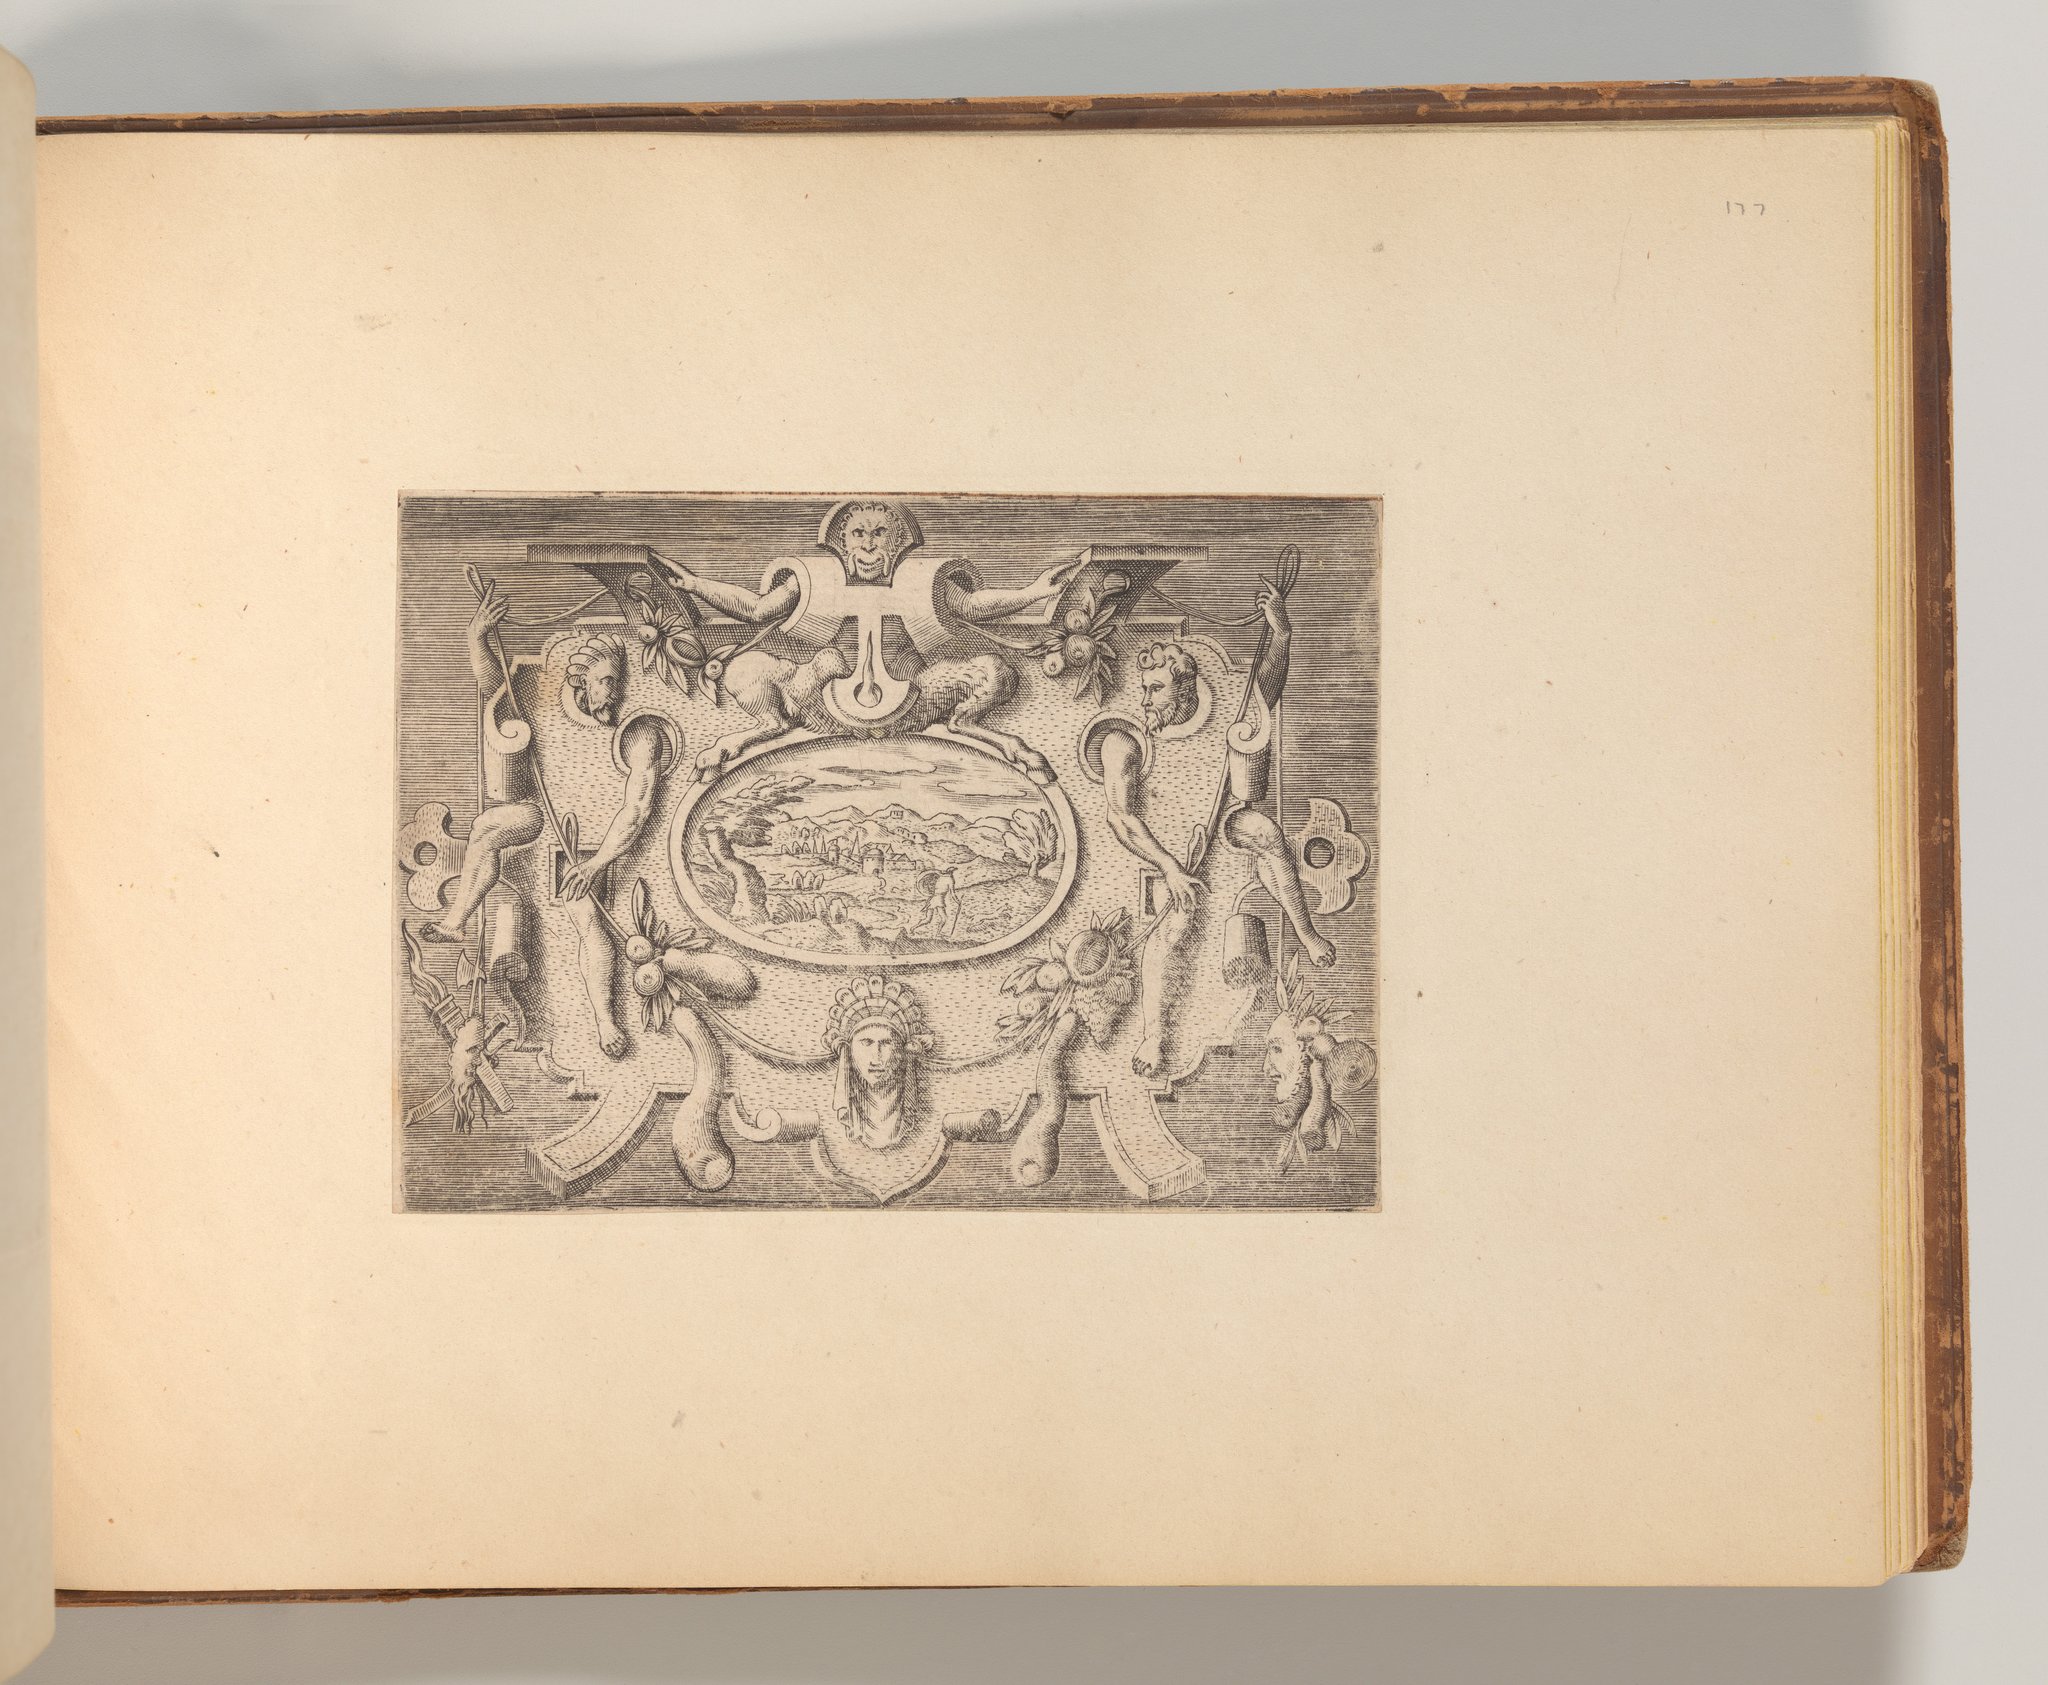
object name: album print ornament architecture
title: Series of Cartouches, in: Targhe ed altri ornati di varie e capricciose invenzioni (Cartouches and other ornaments of various and capricious invention, page 49)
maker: cornelis bos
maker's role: artist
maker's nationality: netherlandish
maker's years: 1510-1556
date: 1545-1560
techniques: engraving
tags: cartouches,ornament,faces,men